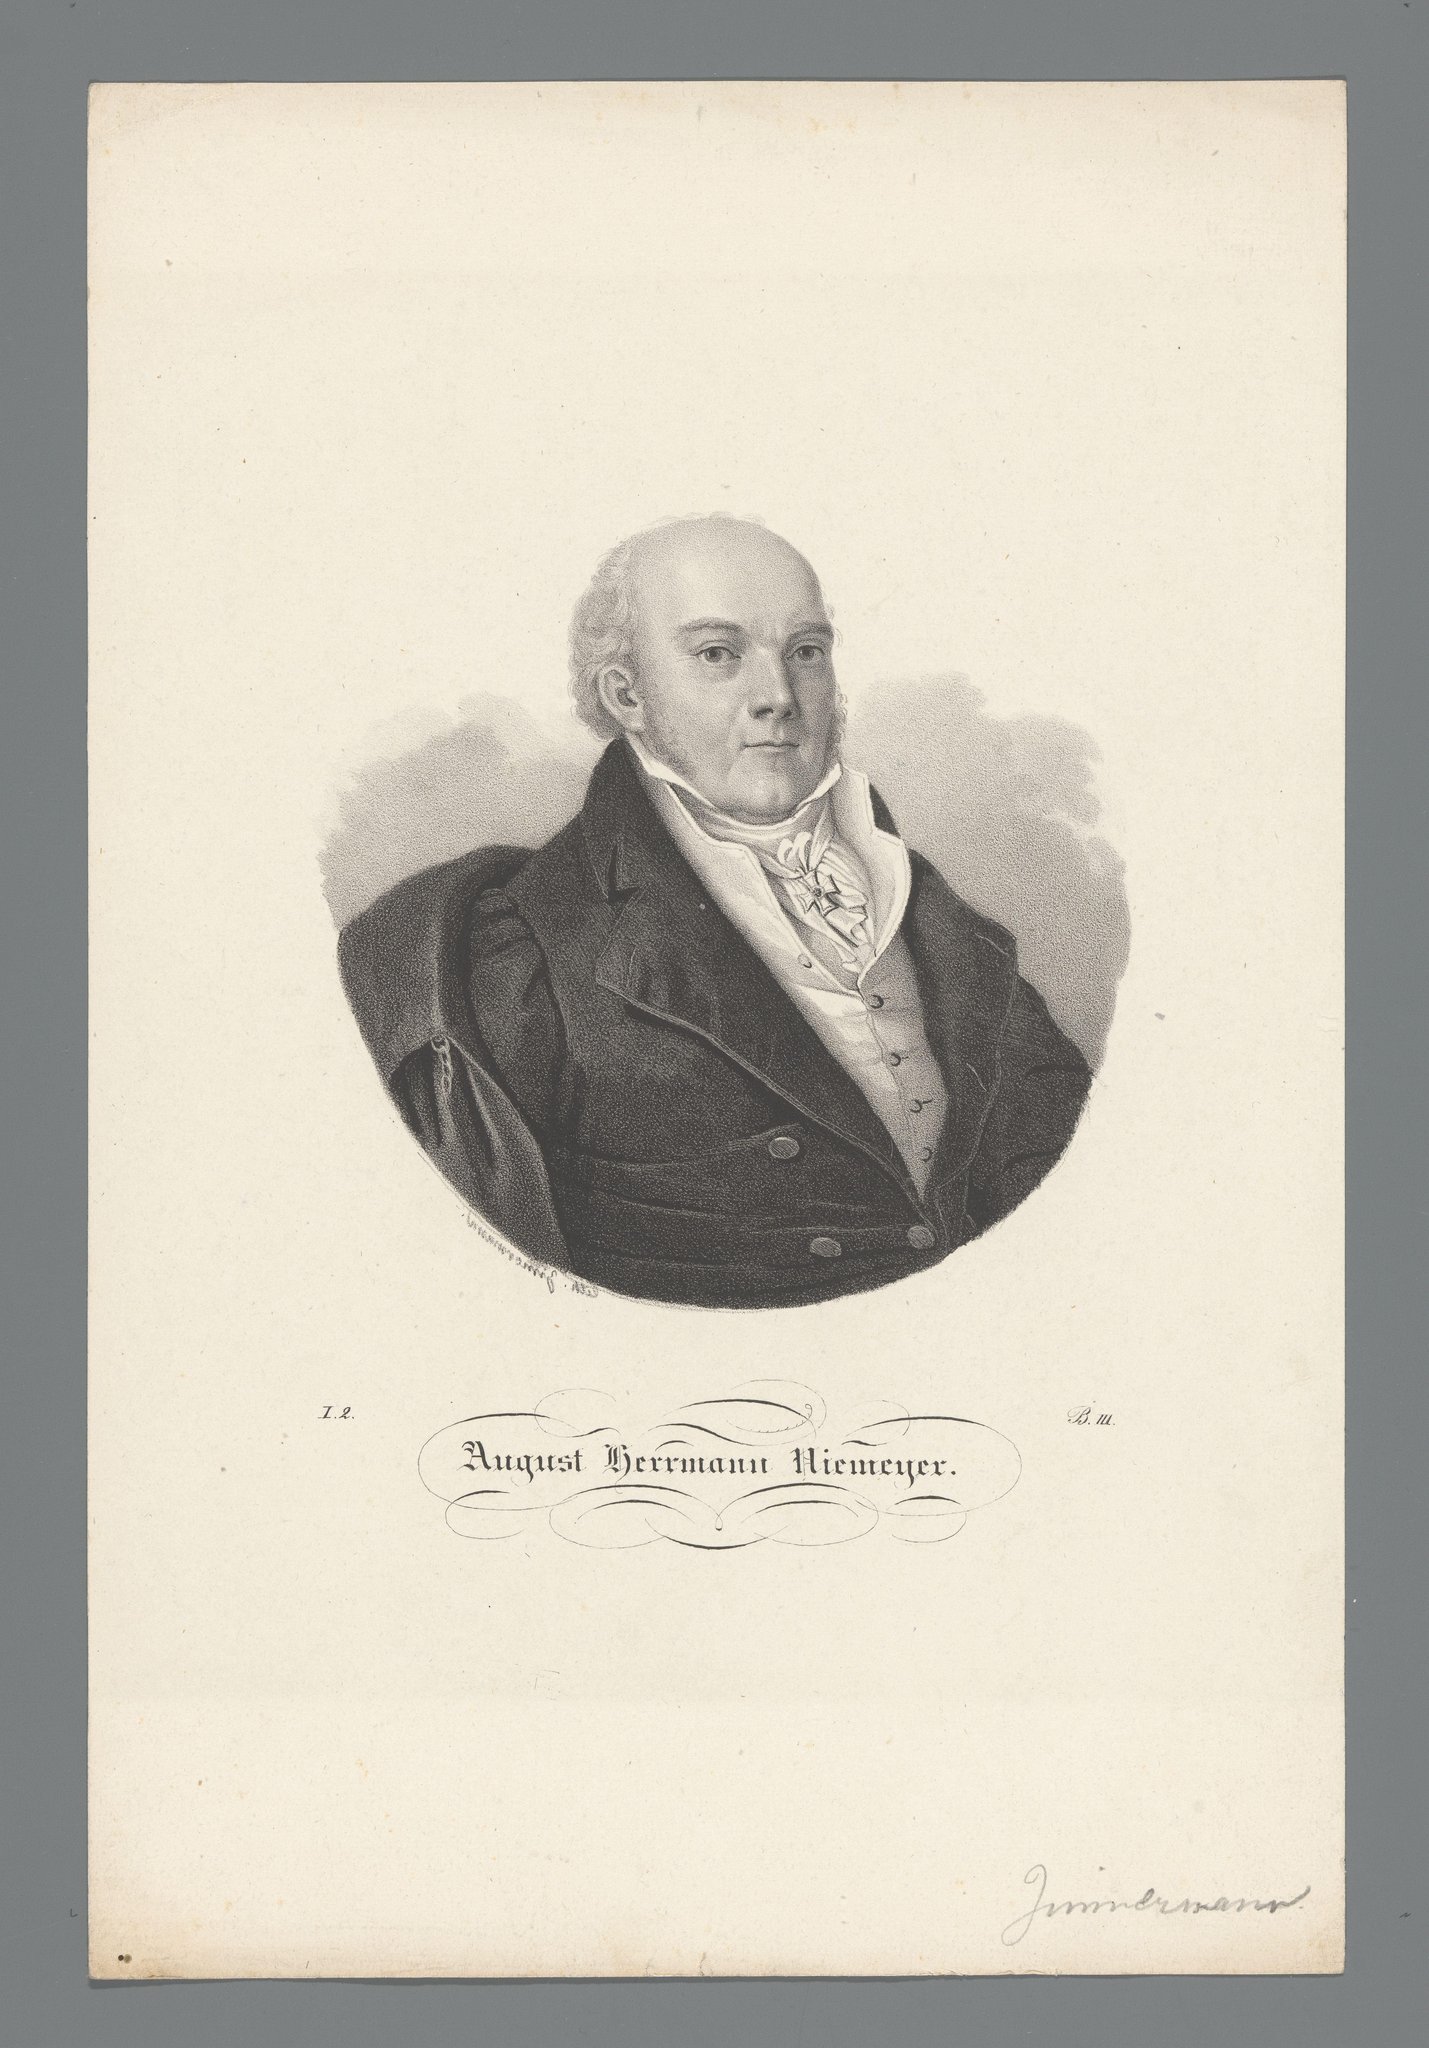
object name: print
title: August Herrmann Niemeyer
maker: friedrich august zimmermann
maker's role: print maker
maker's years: 1805-1876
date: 1815-1876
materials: paper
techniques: lithograph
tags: adult man, historical persons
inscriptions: collector's mark: Lugt 2228